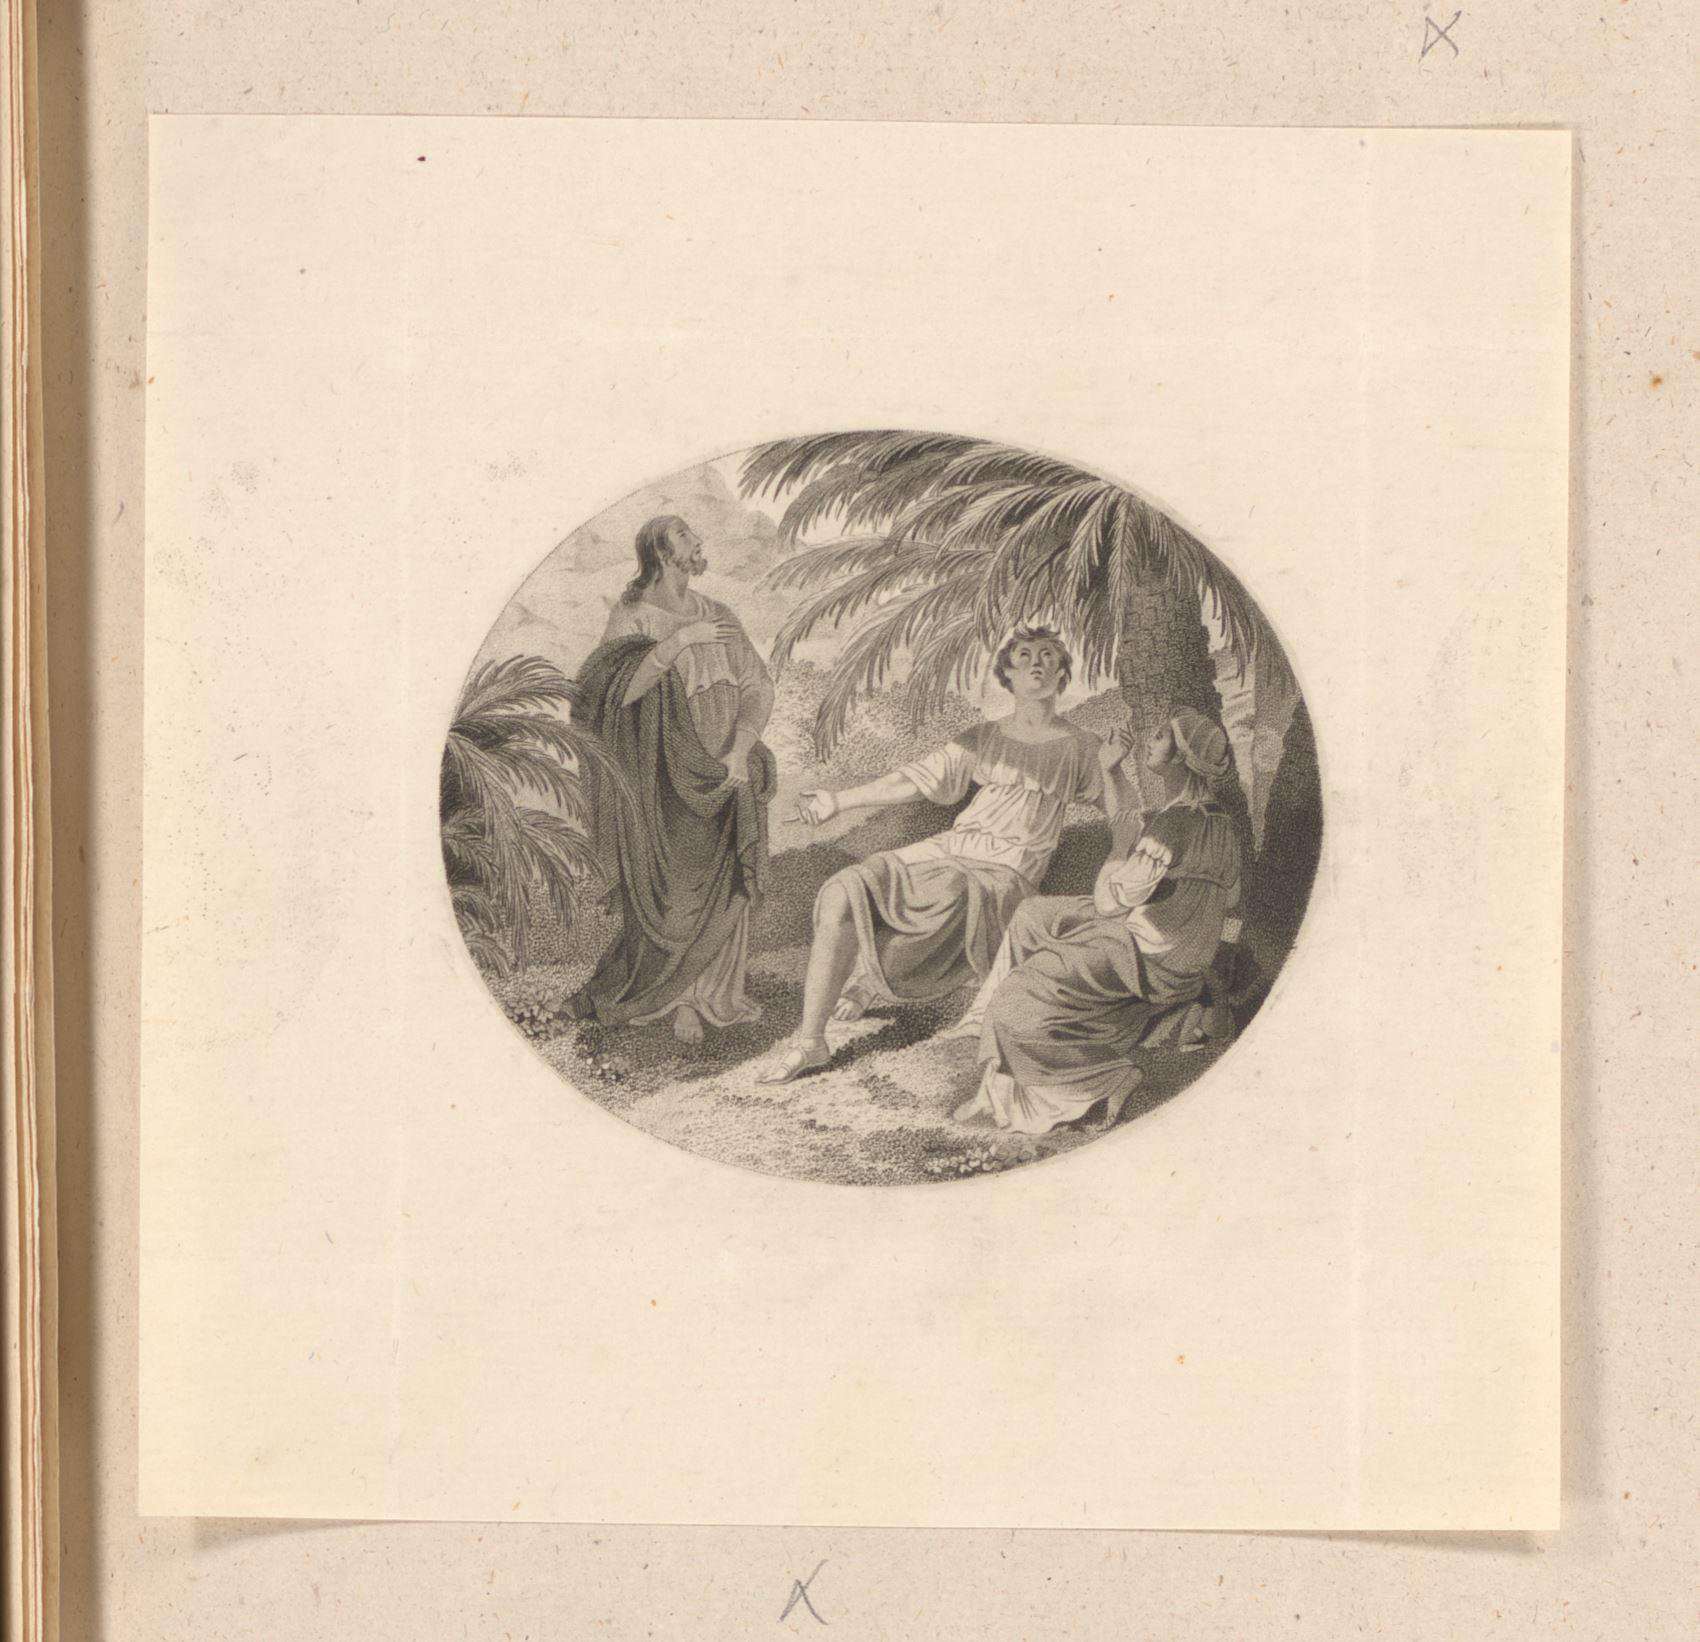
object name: book illustration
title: Christus toont zich na zijn opstanding aan Semida en Cidli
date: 1804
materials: paper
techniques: engraving, etching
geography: haarlem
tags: appearances of christ after the resurrection, raising from the dead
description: Proefdruk van een boekillustratie gebruikt in: Loosjes, Adriaan Pietersz. Semida en Cidli of de Hope der opstanding. Haarlem: A. Loosjes, 1804. Heruitgegeven in 1816.